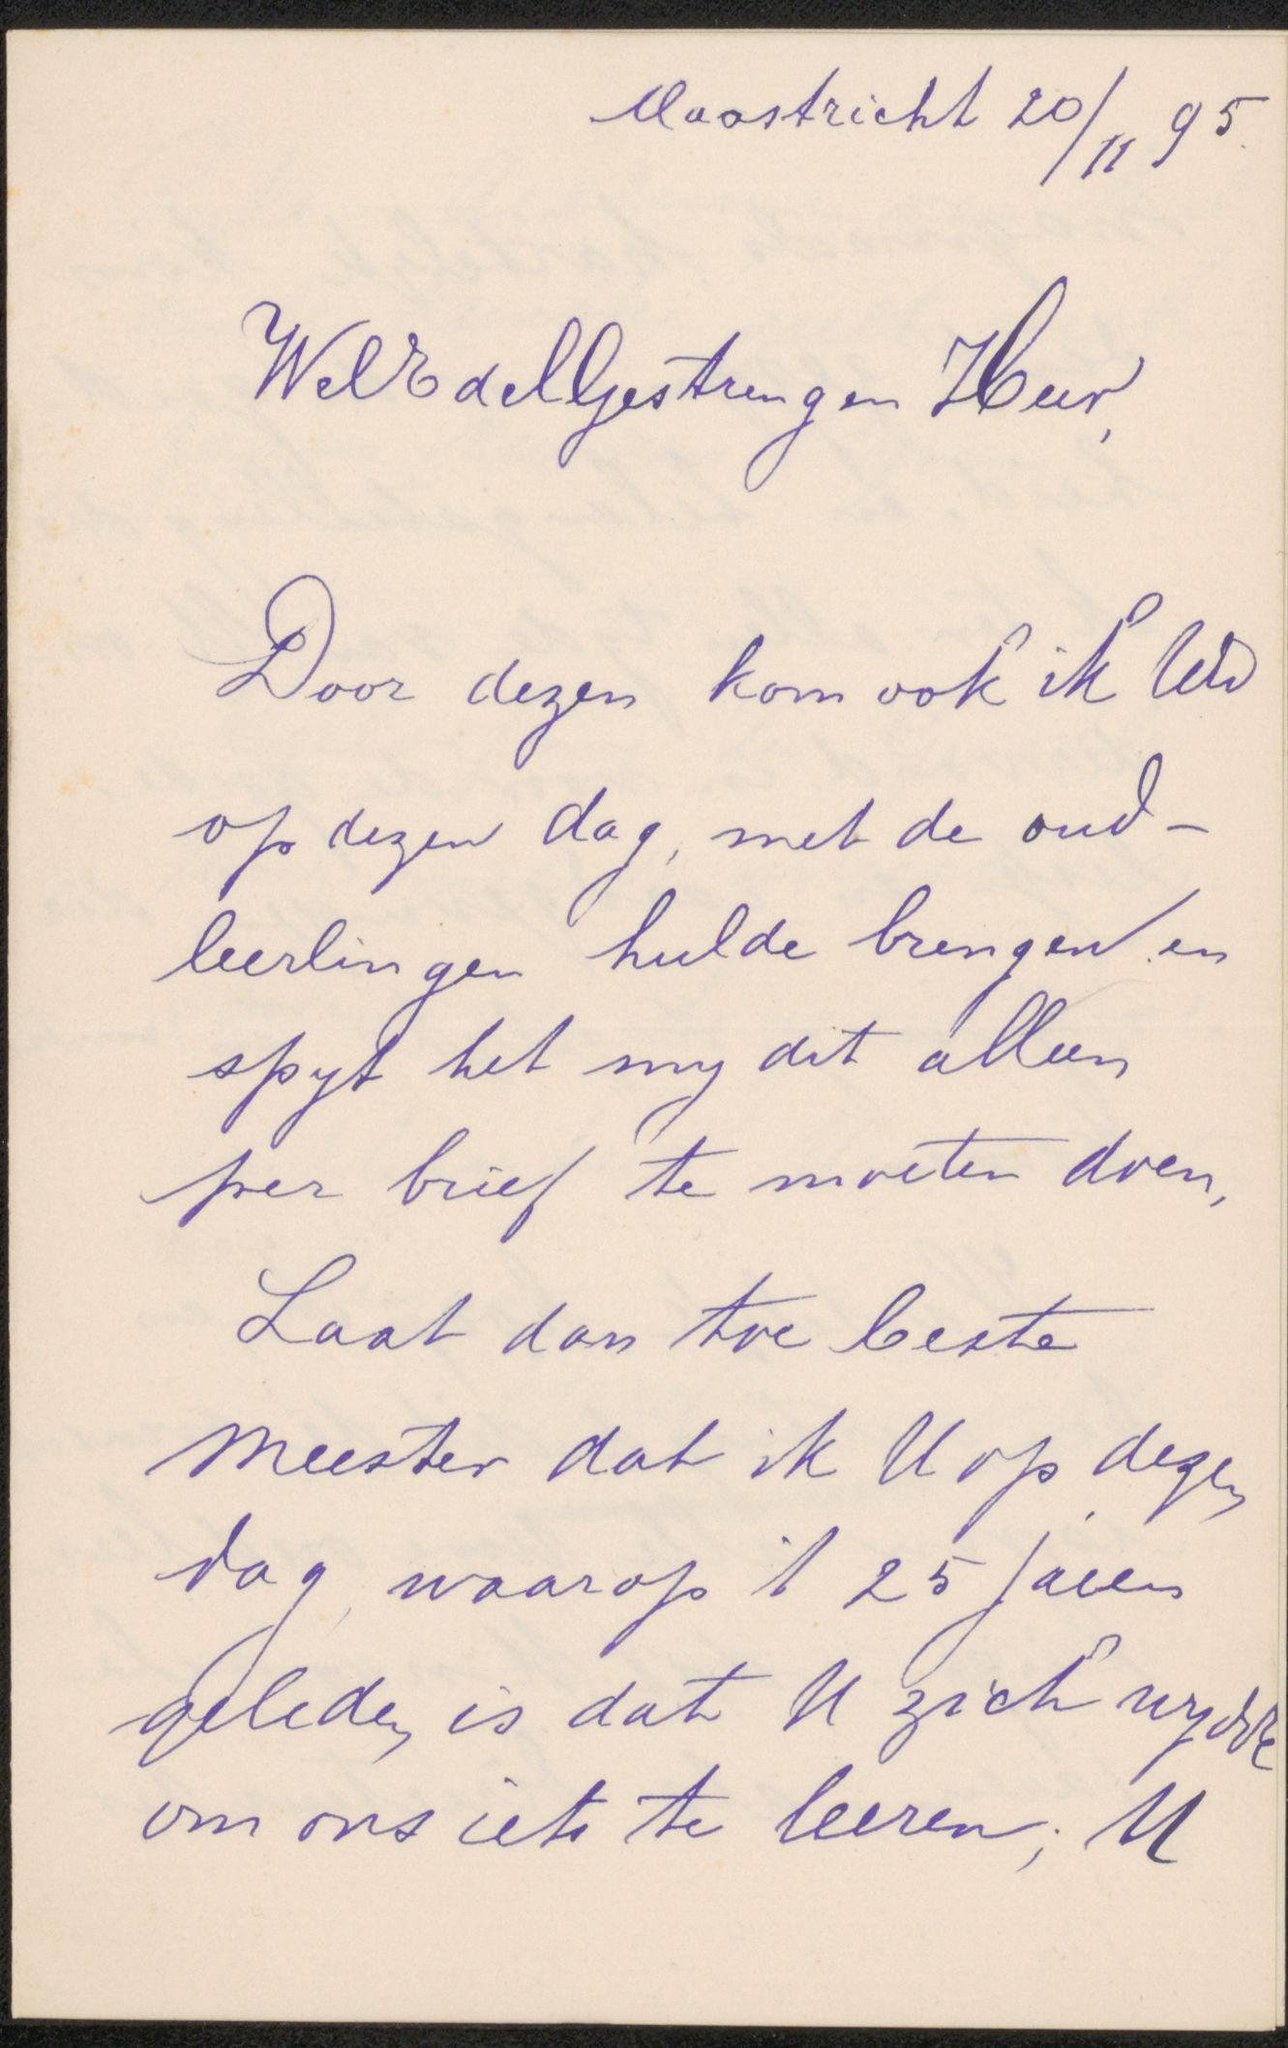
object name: letter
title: Brief aan August Allebé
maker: henri goovaerts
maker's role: conservator, draughtsman, painter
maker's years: 1865-1912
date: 1895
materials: ink, paper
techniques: pen, writing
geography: maastricht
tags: amsterdam, print maker, draughtsman, august allebé, education, tuition of the artist (in general)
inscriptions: watermark